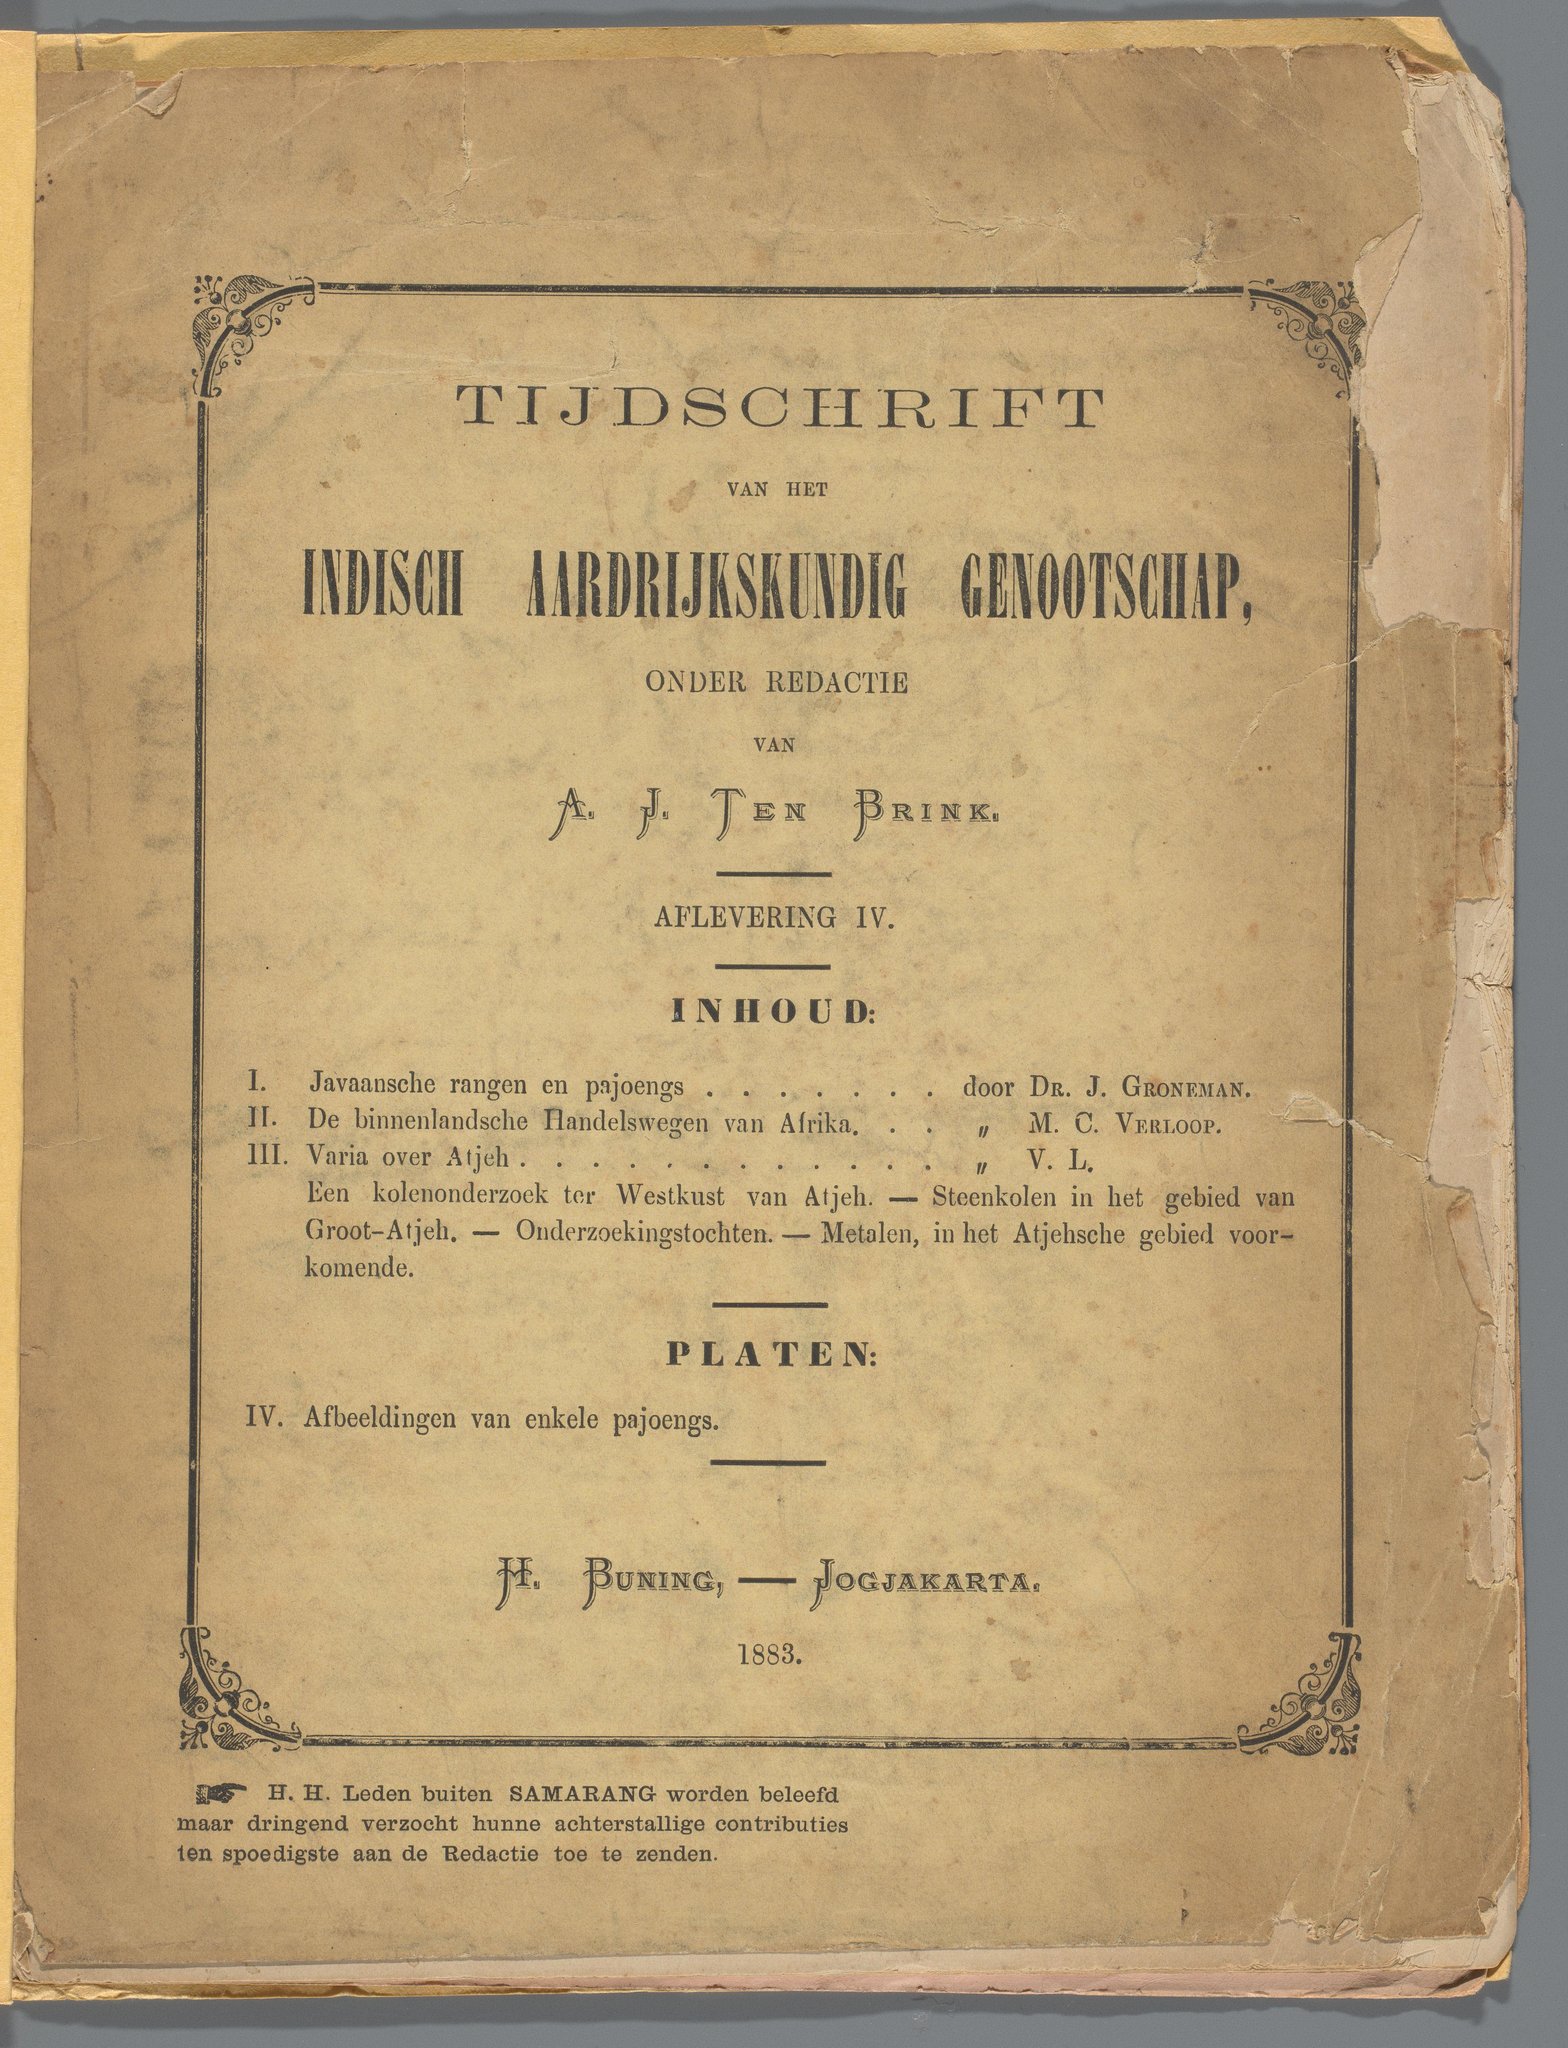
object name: magazine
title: Tijdschrift van het Indisch Aardrijkskundig Genootschap, 1883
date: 1883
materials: paper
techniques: letterpress printing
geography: jogjakarta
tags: jogjakarta